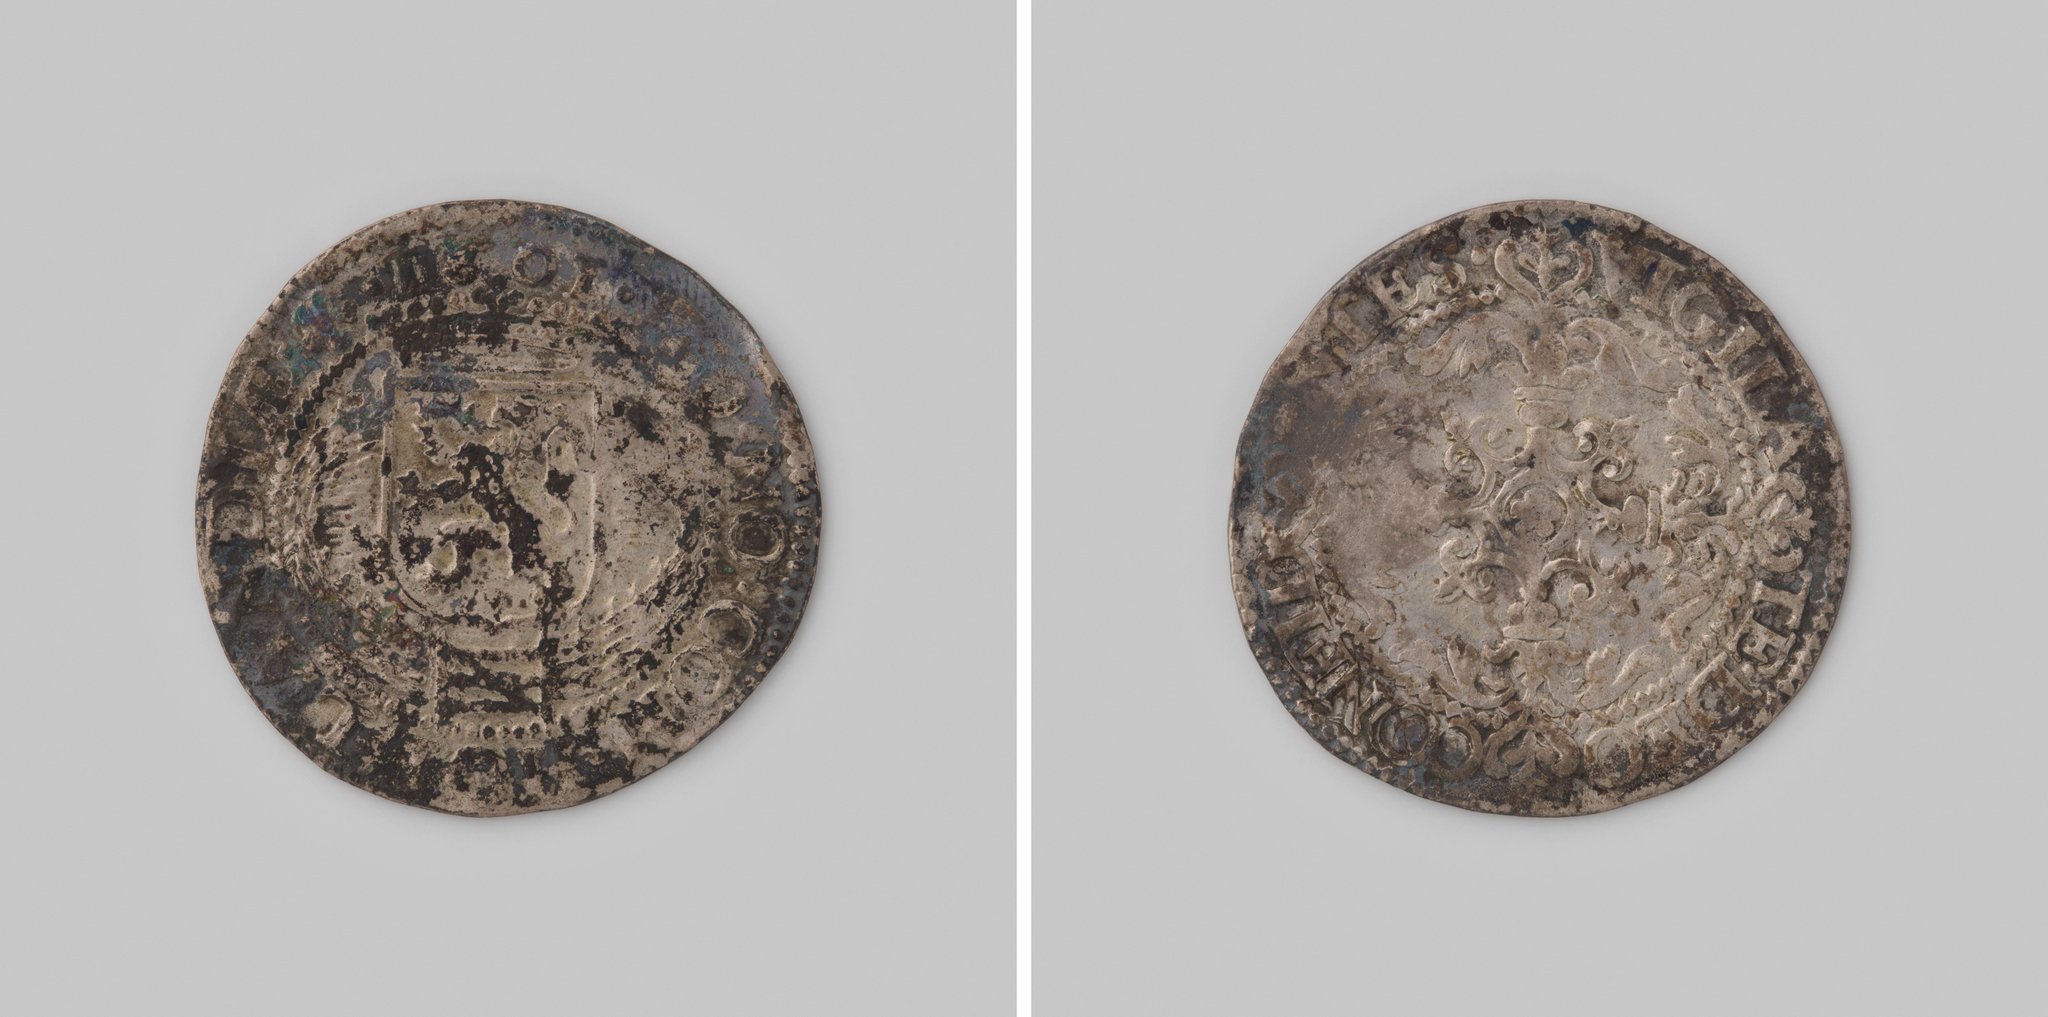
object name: roosschelling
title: Holland, roosschelling, 1601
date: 1601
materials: silver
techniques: striking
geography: dordrecht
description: Zilveren munt. Voorzijde: binnen omheining gekroond wapenschild van Holland. Jaartal boven kroon. Keerzijde: lang, rijk versierd kruis. In het hart een roos.